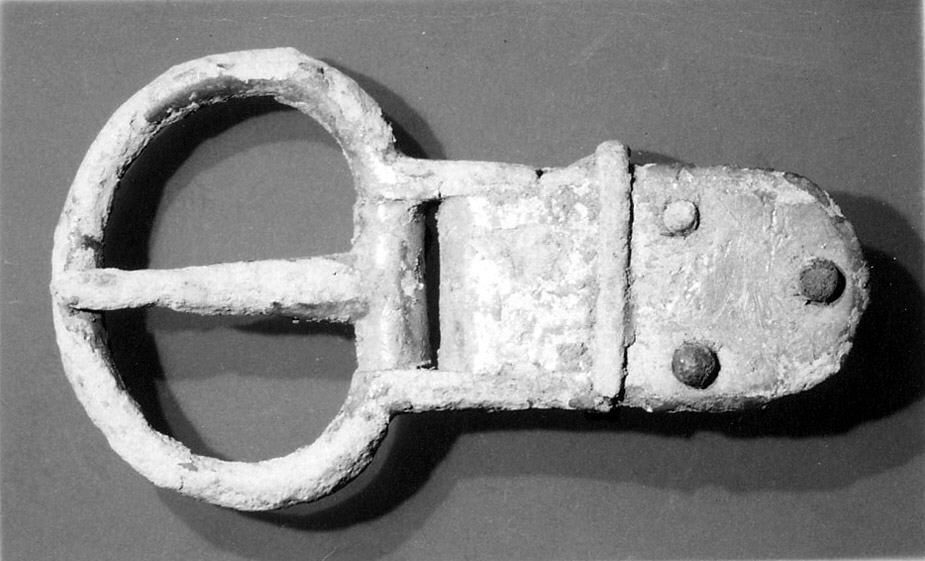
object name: harness and strap buckle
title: Harness and strap buckles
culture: japanese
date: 200-538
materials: gilt bronze